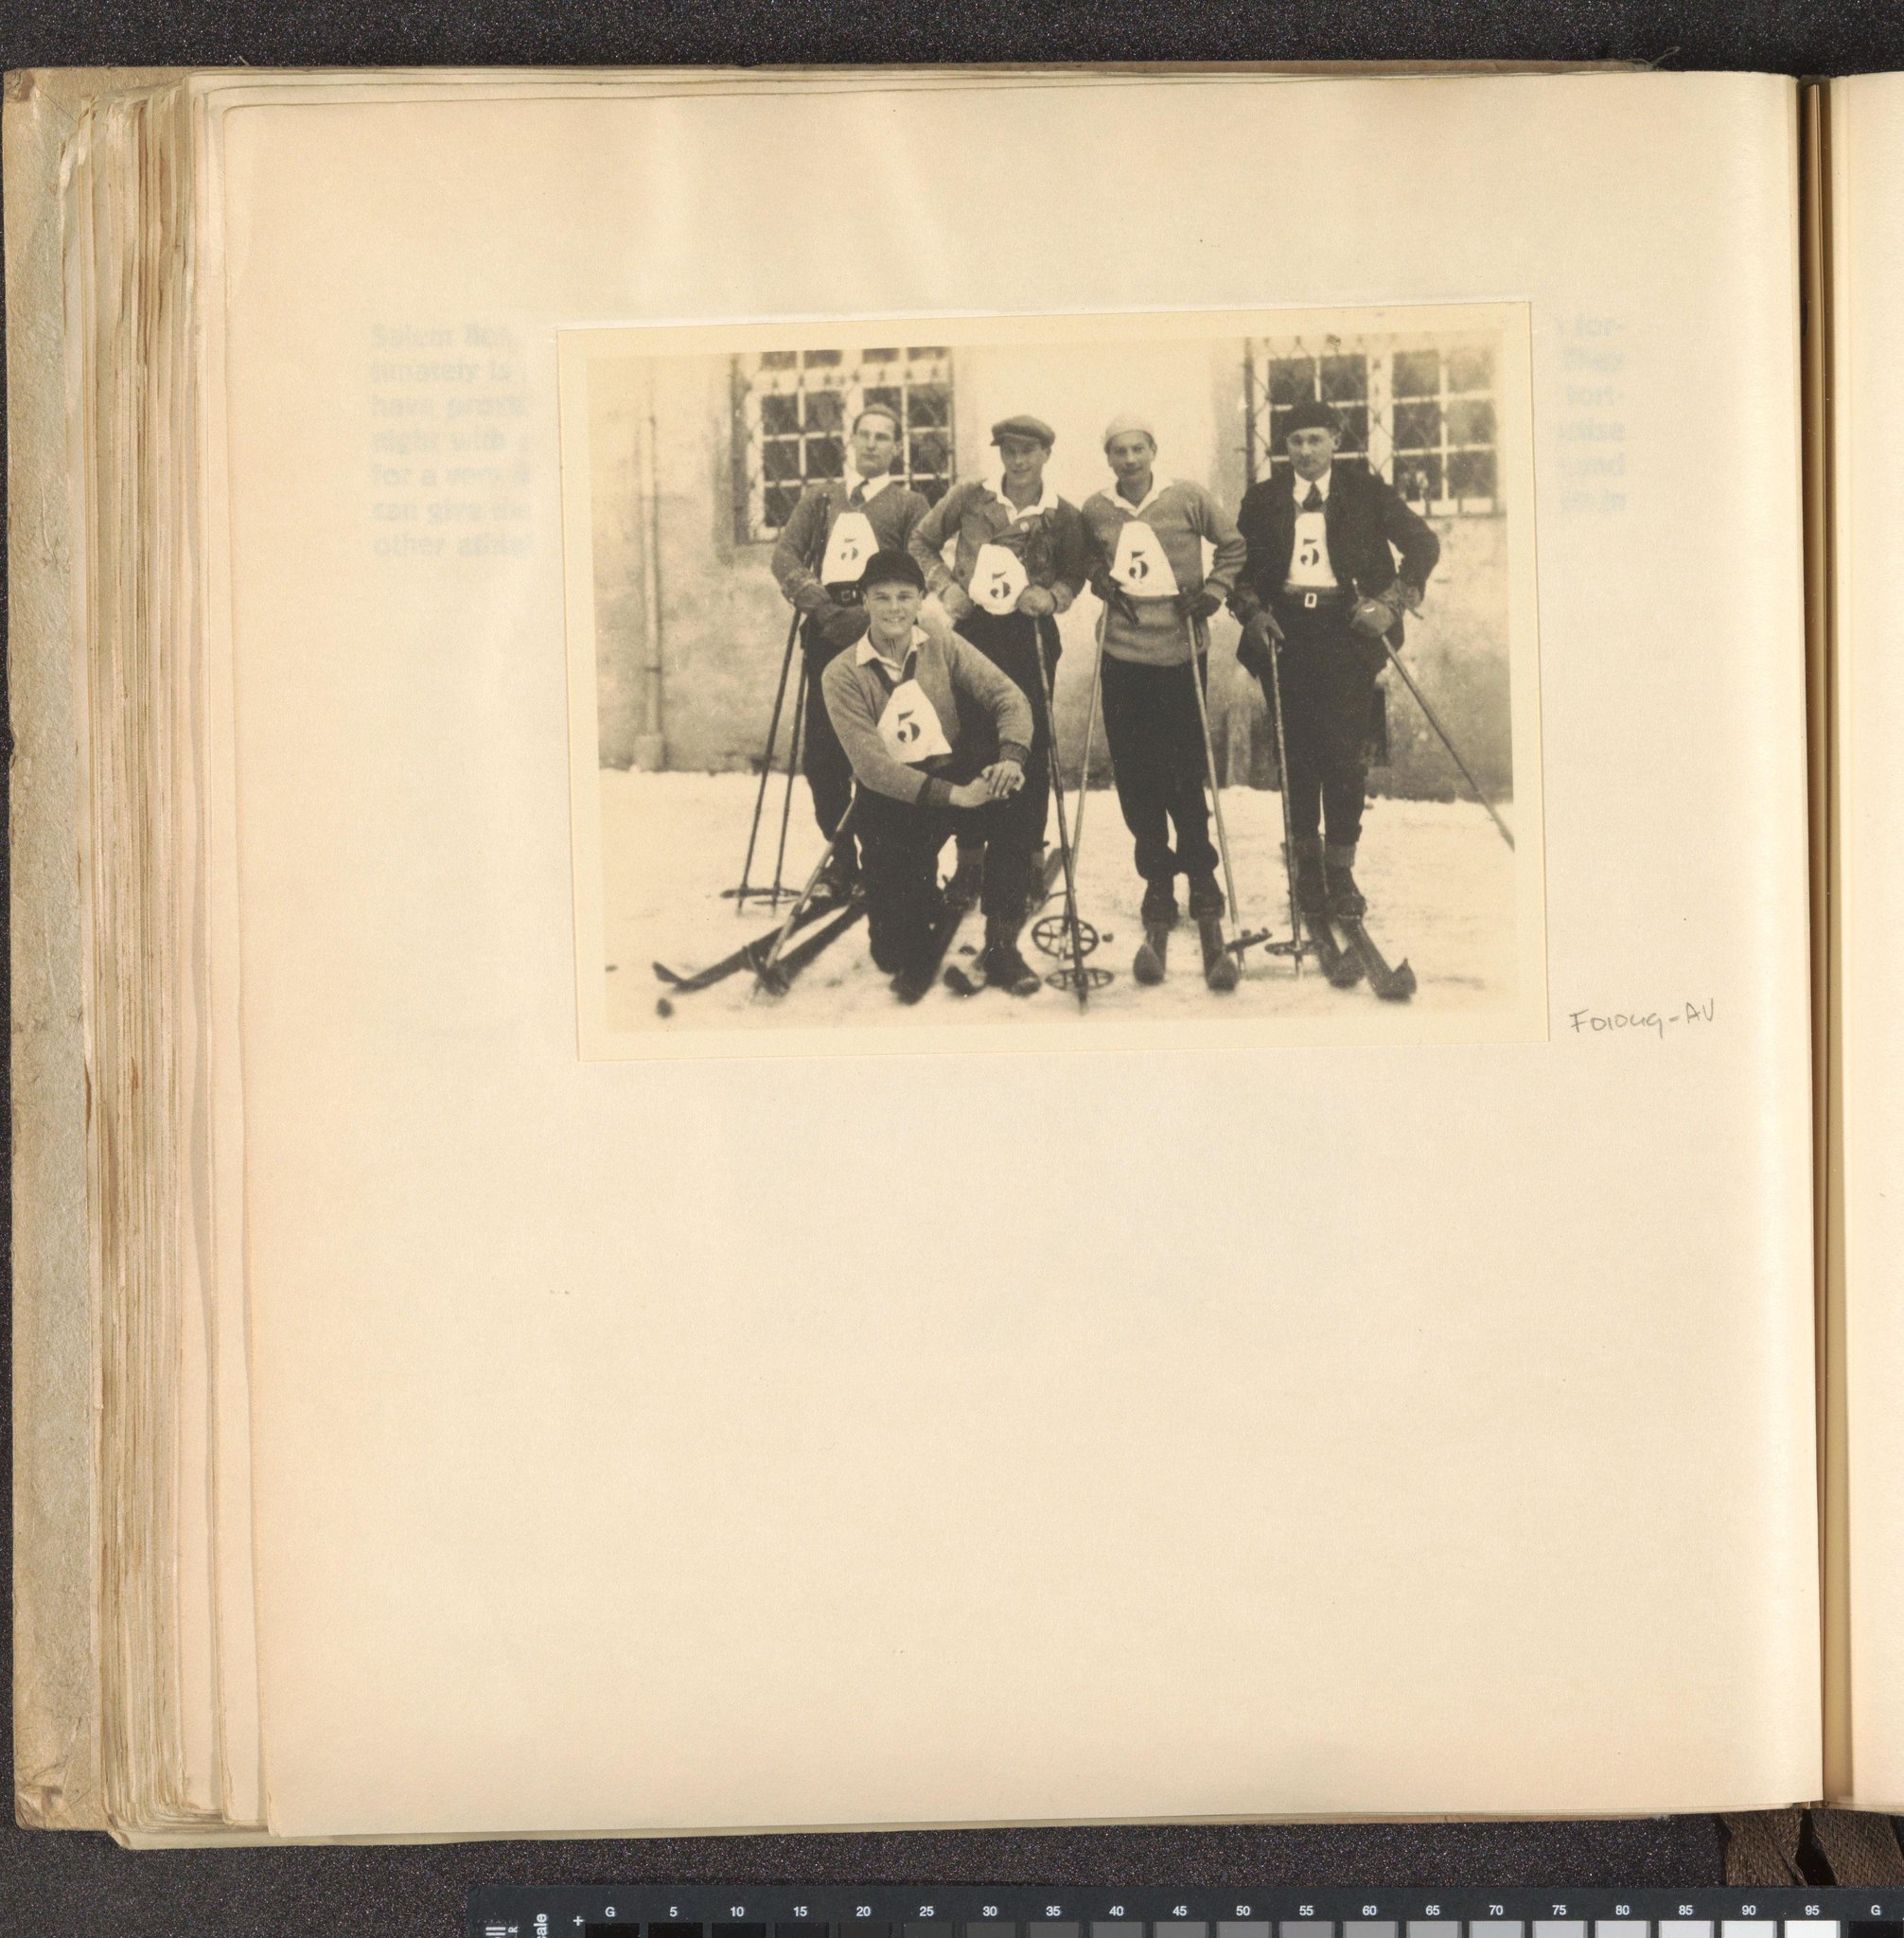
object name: photograph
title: Groepsportret van leerlingen van Schule Schloss Salem tijdens een skitocht in Unterengadin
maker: Anonymous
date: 1929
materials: photographic support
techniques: gelatin silver print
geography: graubunden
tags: skis (winter sports), education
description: Onderdeel van Fotoalbum van Schule Schloss Salem.